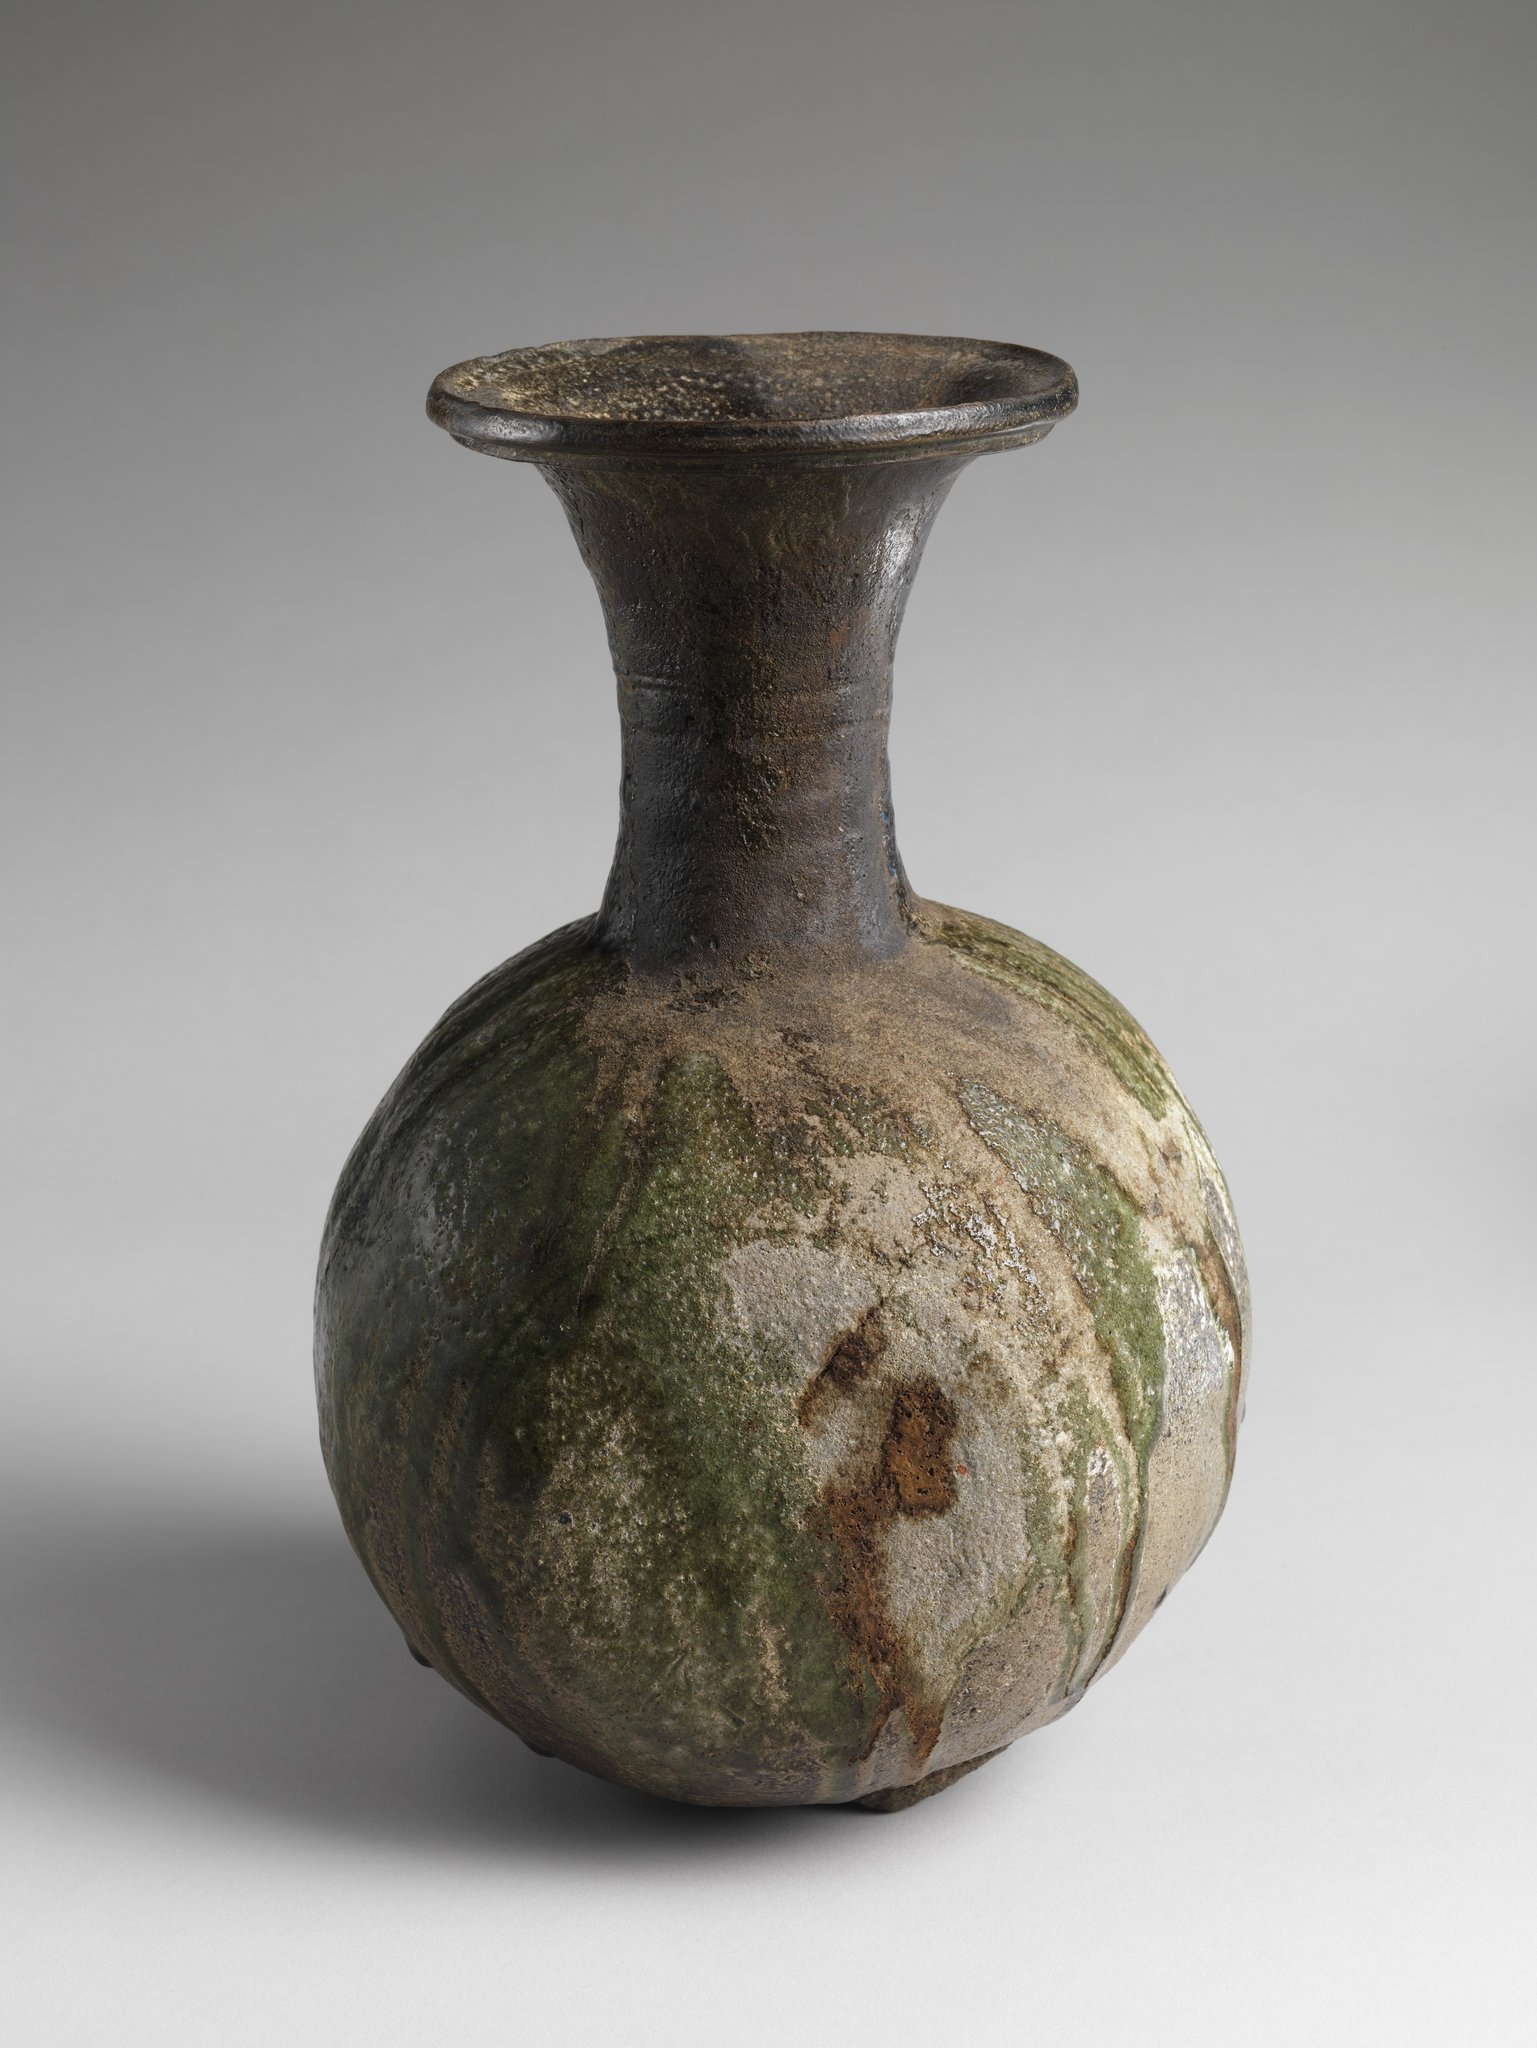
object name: jar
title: Long-Necked Jar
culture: japanese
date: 200-538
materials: wood, glaze, stoneware